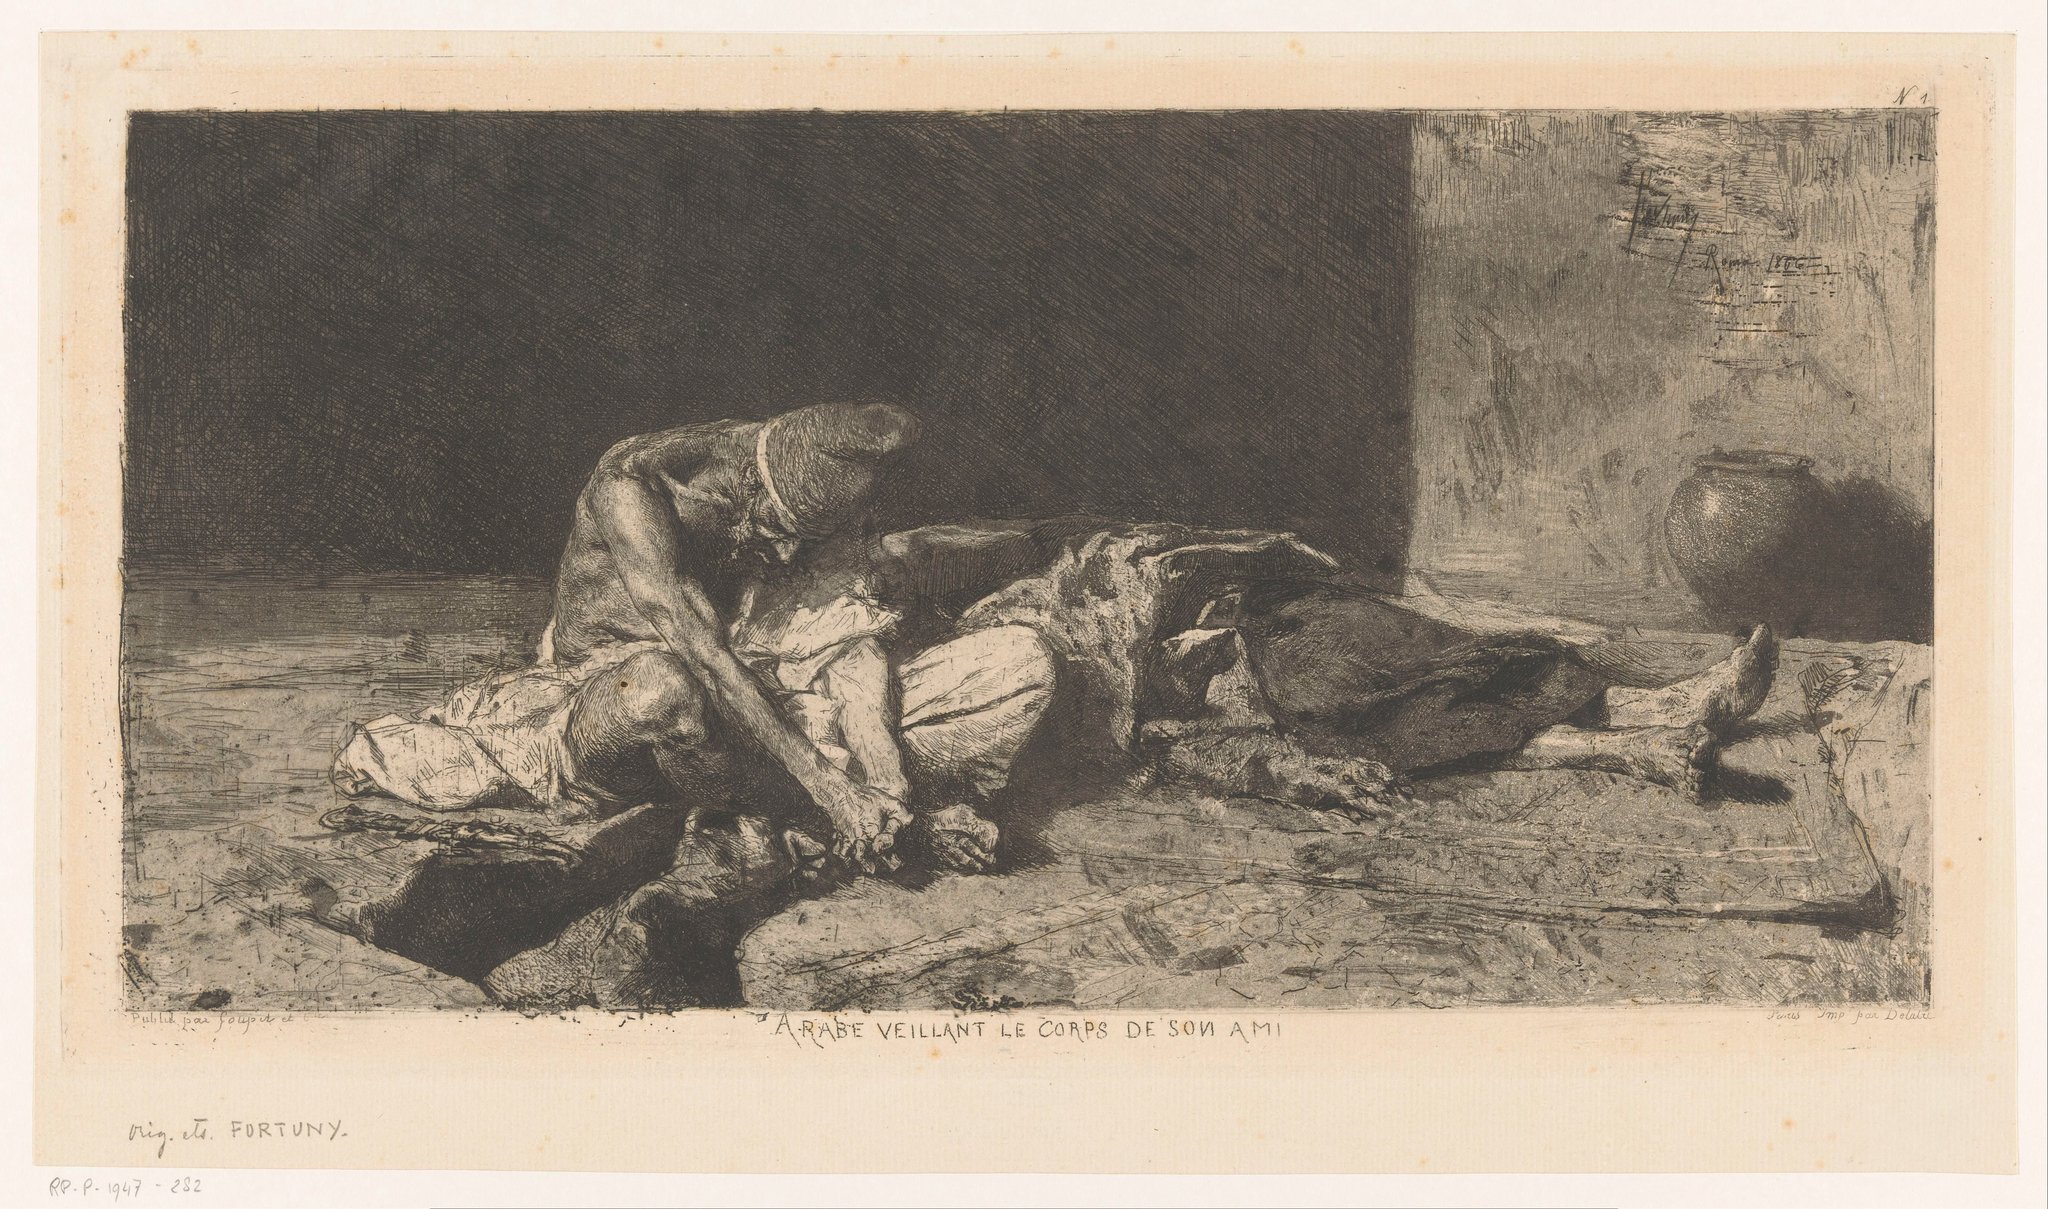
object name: print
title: Arabe veillant sur le corps de son ami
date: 1866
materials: paper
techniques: aquatint, etching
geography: paris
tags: the corpse, sitting on the ground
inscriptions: collector's mark: Lugt 2228